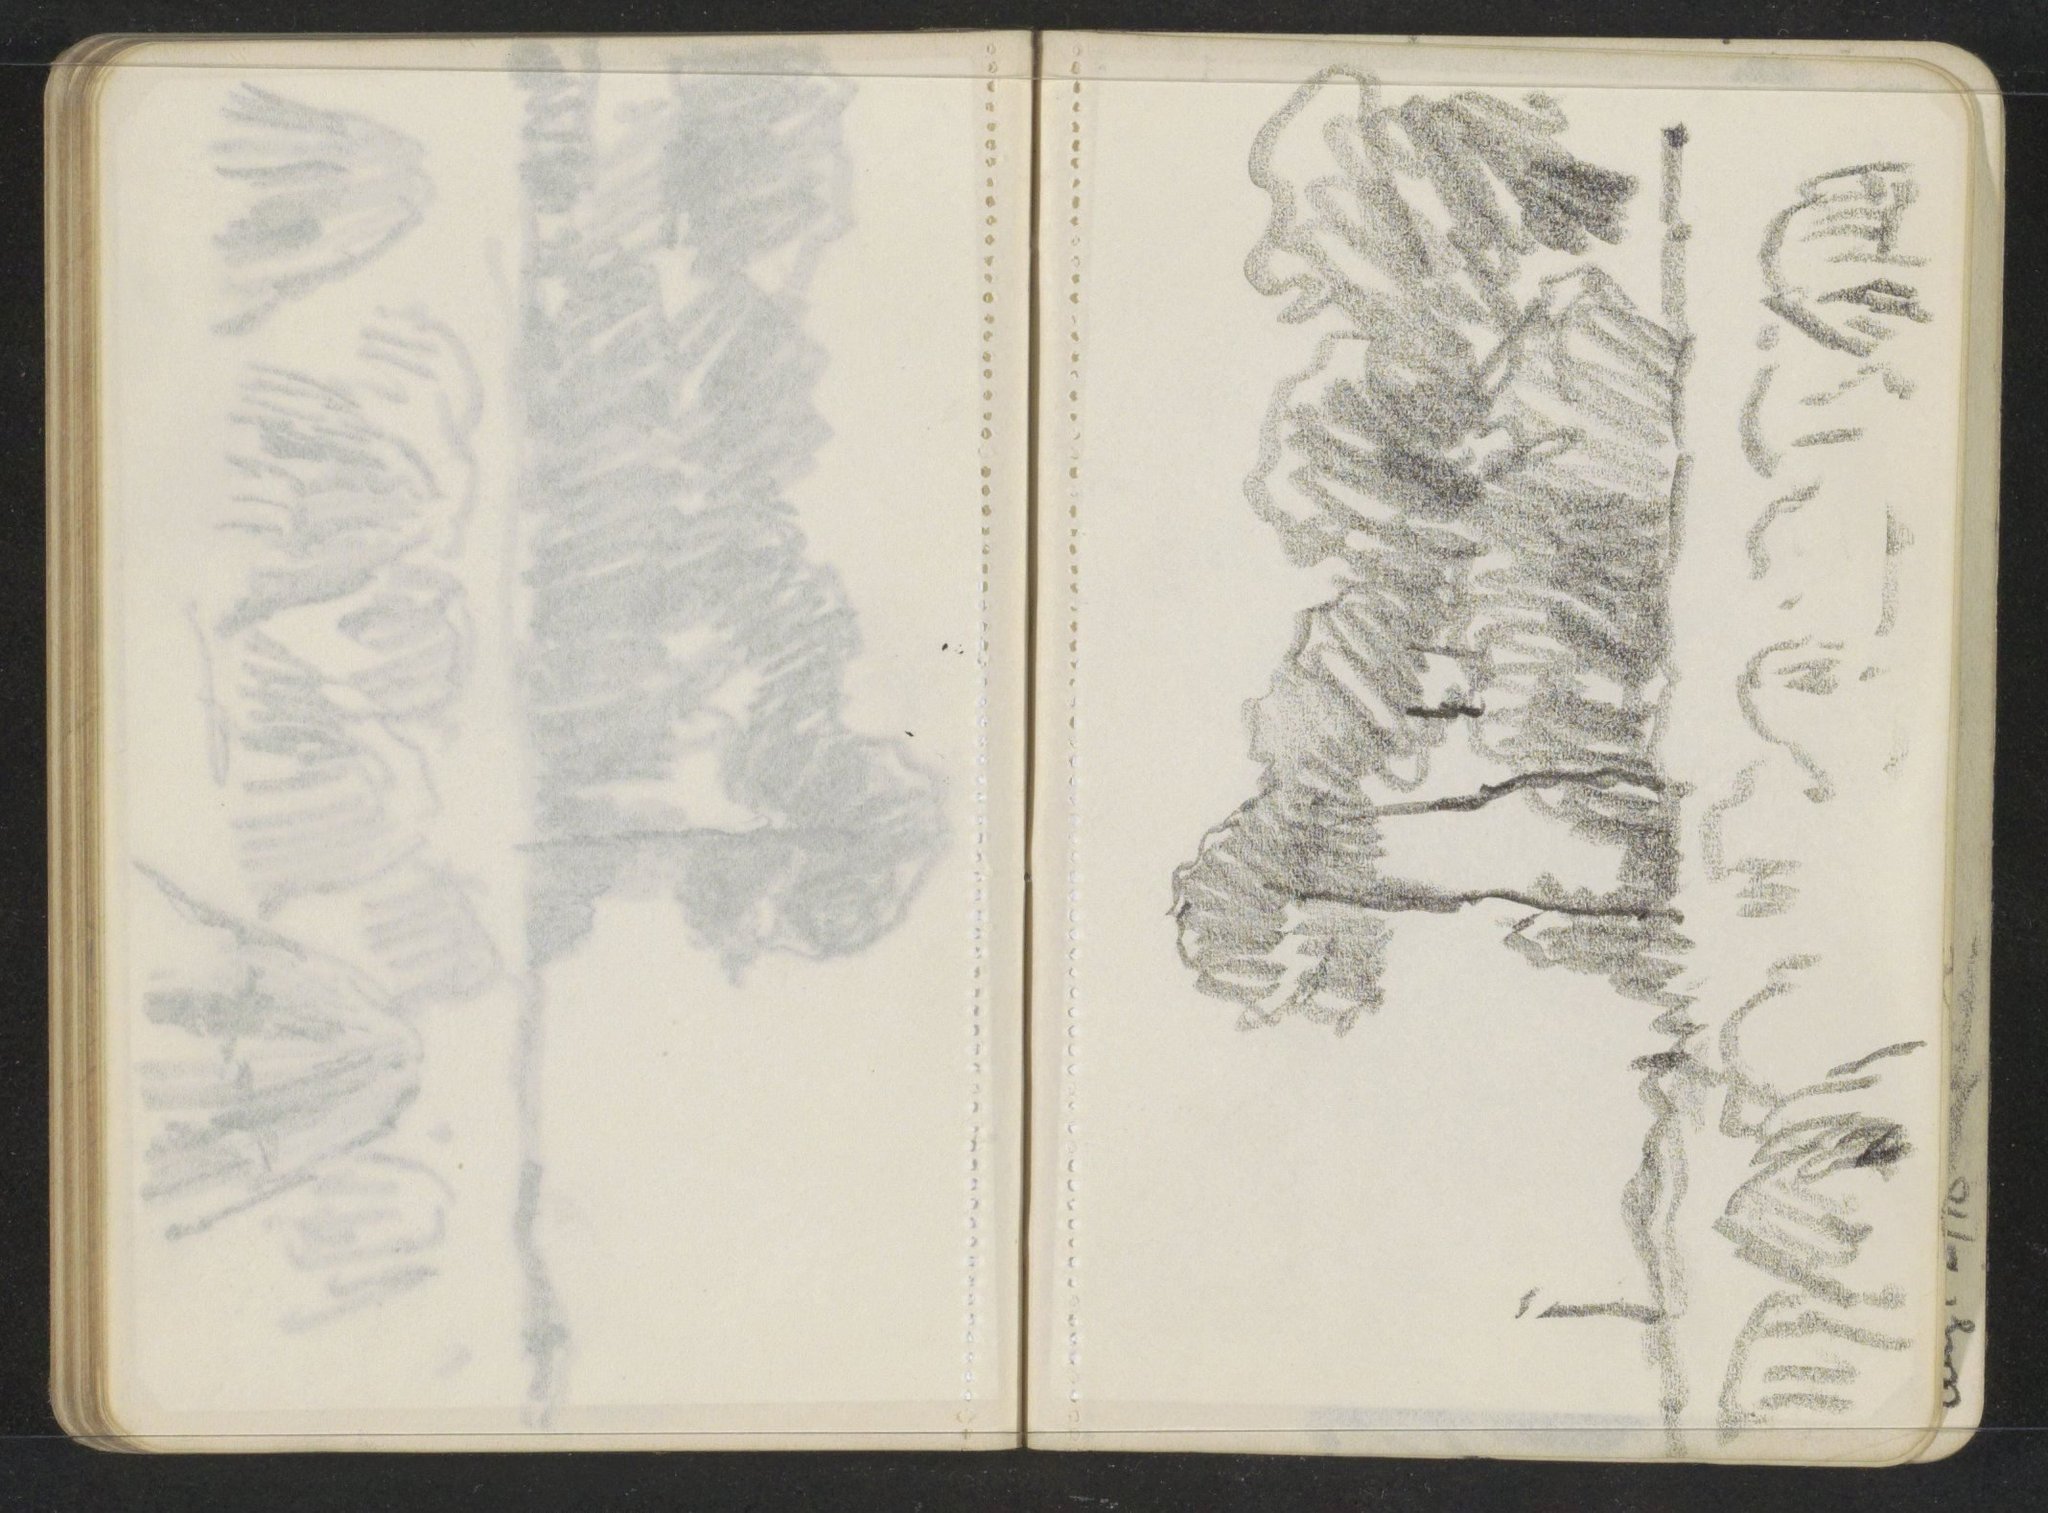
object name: sketchbook leaf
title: Hooioppers in een weiland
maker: alexander shilling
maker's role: draughtsman, print maker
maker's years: 1859-1937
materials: paper, pencil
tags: hay-cock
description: Blad 67 recto uit een schetsboek met 91 bladen.